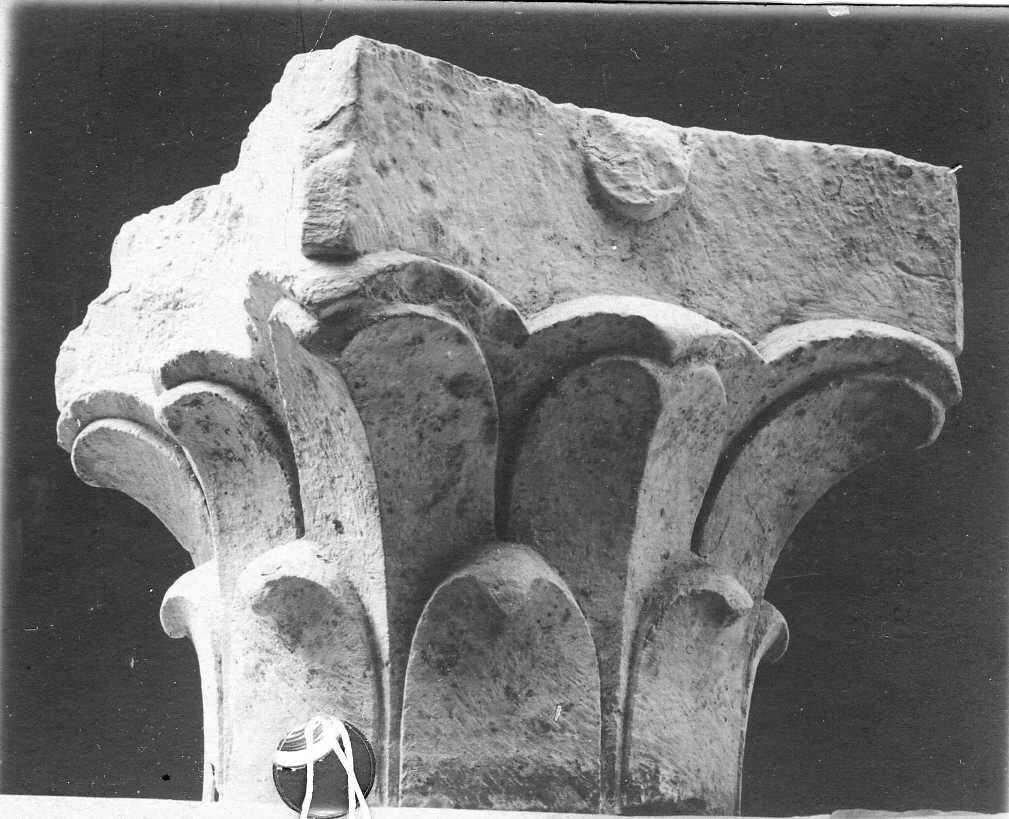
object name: capital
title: Capital from a Reused Pharaonic Block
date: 301-500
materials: limestone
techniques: carving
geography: egypt